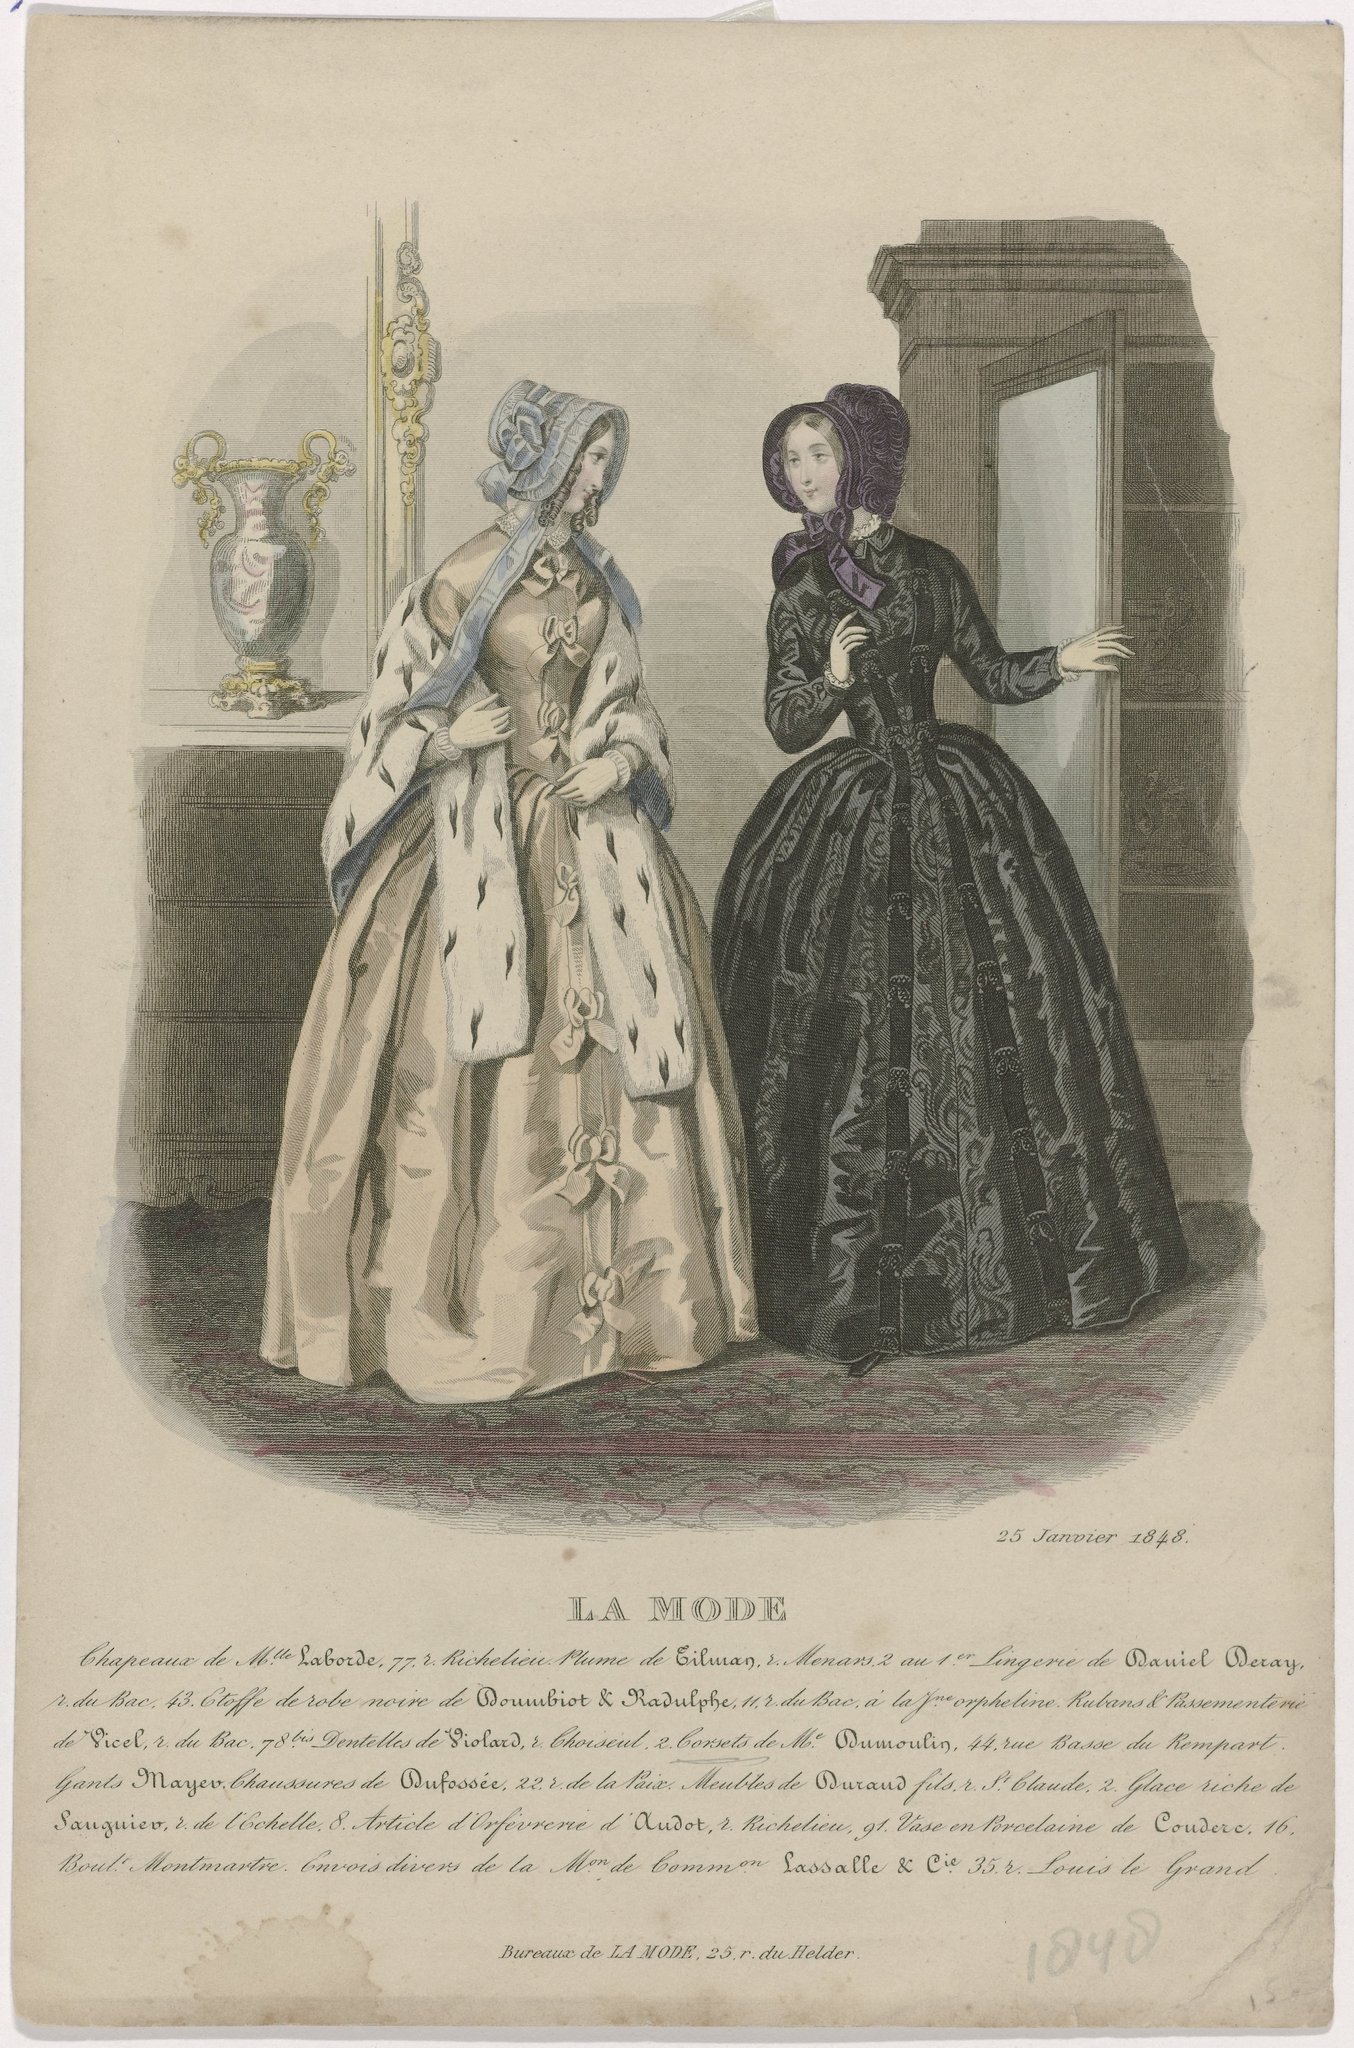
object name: fashion print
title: La Mode, 25 janvier 1848 : Chapeau de Mme Labord (...)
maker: Anonymous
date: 1848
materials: paper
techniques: engraving, hand coloring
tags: clothing for the upper part of the body (shawl) (+ women's clothes), ornamental parts of clothing (+ women's clothes), border, ribbon, braid (+ women's clothes), fashion plates, head-gear: hat (+ women's clothes), shoes, sandals (+ women's clothes), gloves, mittens, etc. (+ women's clothes), dress, gown (+ women's clothes), clothing for the upper part of the body (shawl) (+ fur used for clothes), furniture and household effects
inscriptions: address: ‘Bureaux de La Mode, 25, r. du Helder’, title: ‘La Mode’, caption: ‘Chapeau de M.lle Laborde, 77. r. Richelieu. Plume de Tilman. r. Menars. 2 au 1. er Lingerie de Daniel Deray, r. du Bac, 43. Etoffe de robe noire de Doumbiot & Radulphe, 11, r. du Bac, à la J.ne orpheline. Rubans & Passementerie de Vicel, r. du Bac. 78.bis Dentelles de Violard, r. Choiseul, 2. Corsets de M.e Dumoulin, 44. rue Basse du Rempart. Gants Mayer. Chaussures de Dufossée, 22. r. de la Paix. Meubles de Durand fils. r. S.t Claude. 2. Glace riche de Sauguiev, r. de l'Echelle. 8. Article d'Orfévrerie d'Audot, r. Richelieu, 91. Vase en porcelaine de Couderc, 16. Boul.t Montmartre. Envois divers de la M.on de Comm.on Lassalle & C.ie. 35. r. Louis le Grand.’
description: Twee vrouwen in een interieur, van wie één een kastdeur openhoudt. Volgens het onderschrift: hoeden van Laborde. Stof van de zwarte japon van Doumbiot & Radulphe, 'à la jeune orpheline'. Vaas van porselein van Couderc. Hieronder enkele regels reclametekst voor verschillende producten. Prent uit het modetijdschrift La Mode (1829-1855).